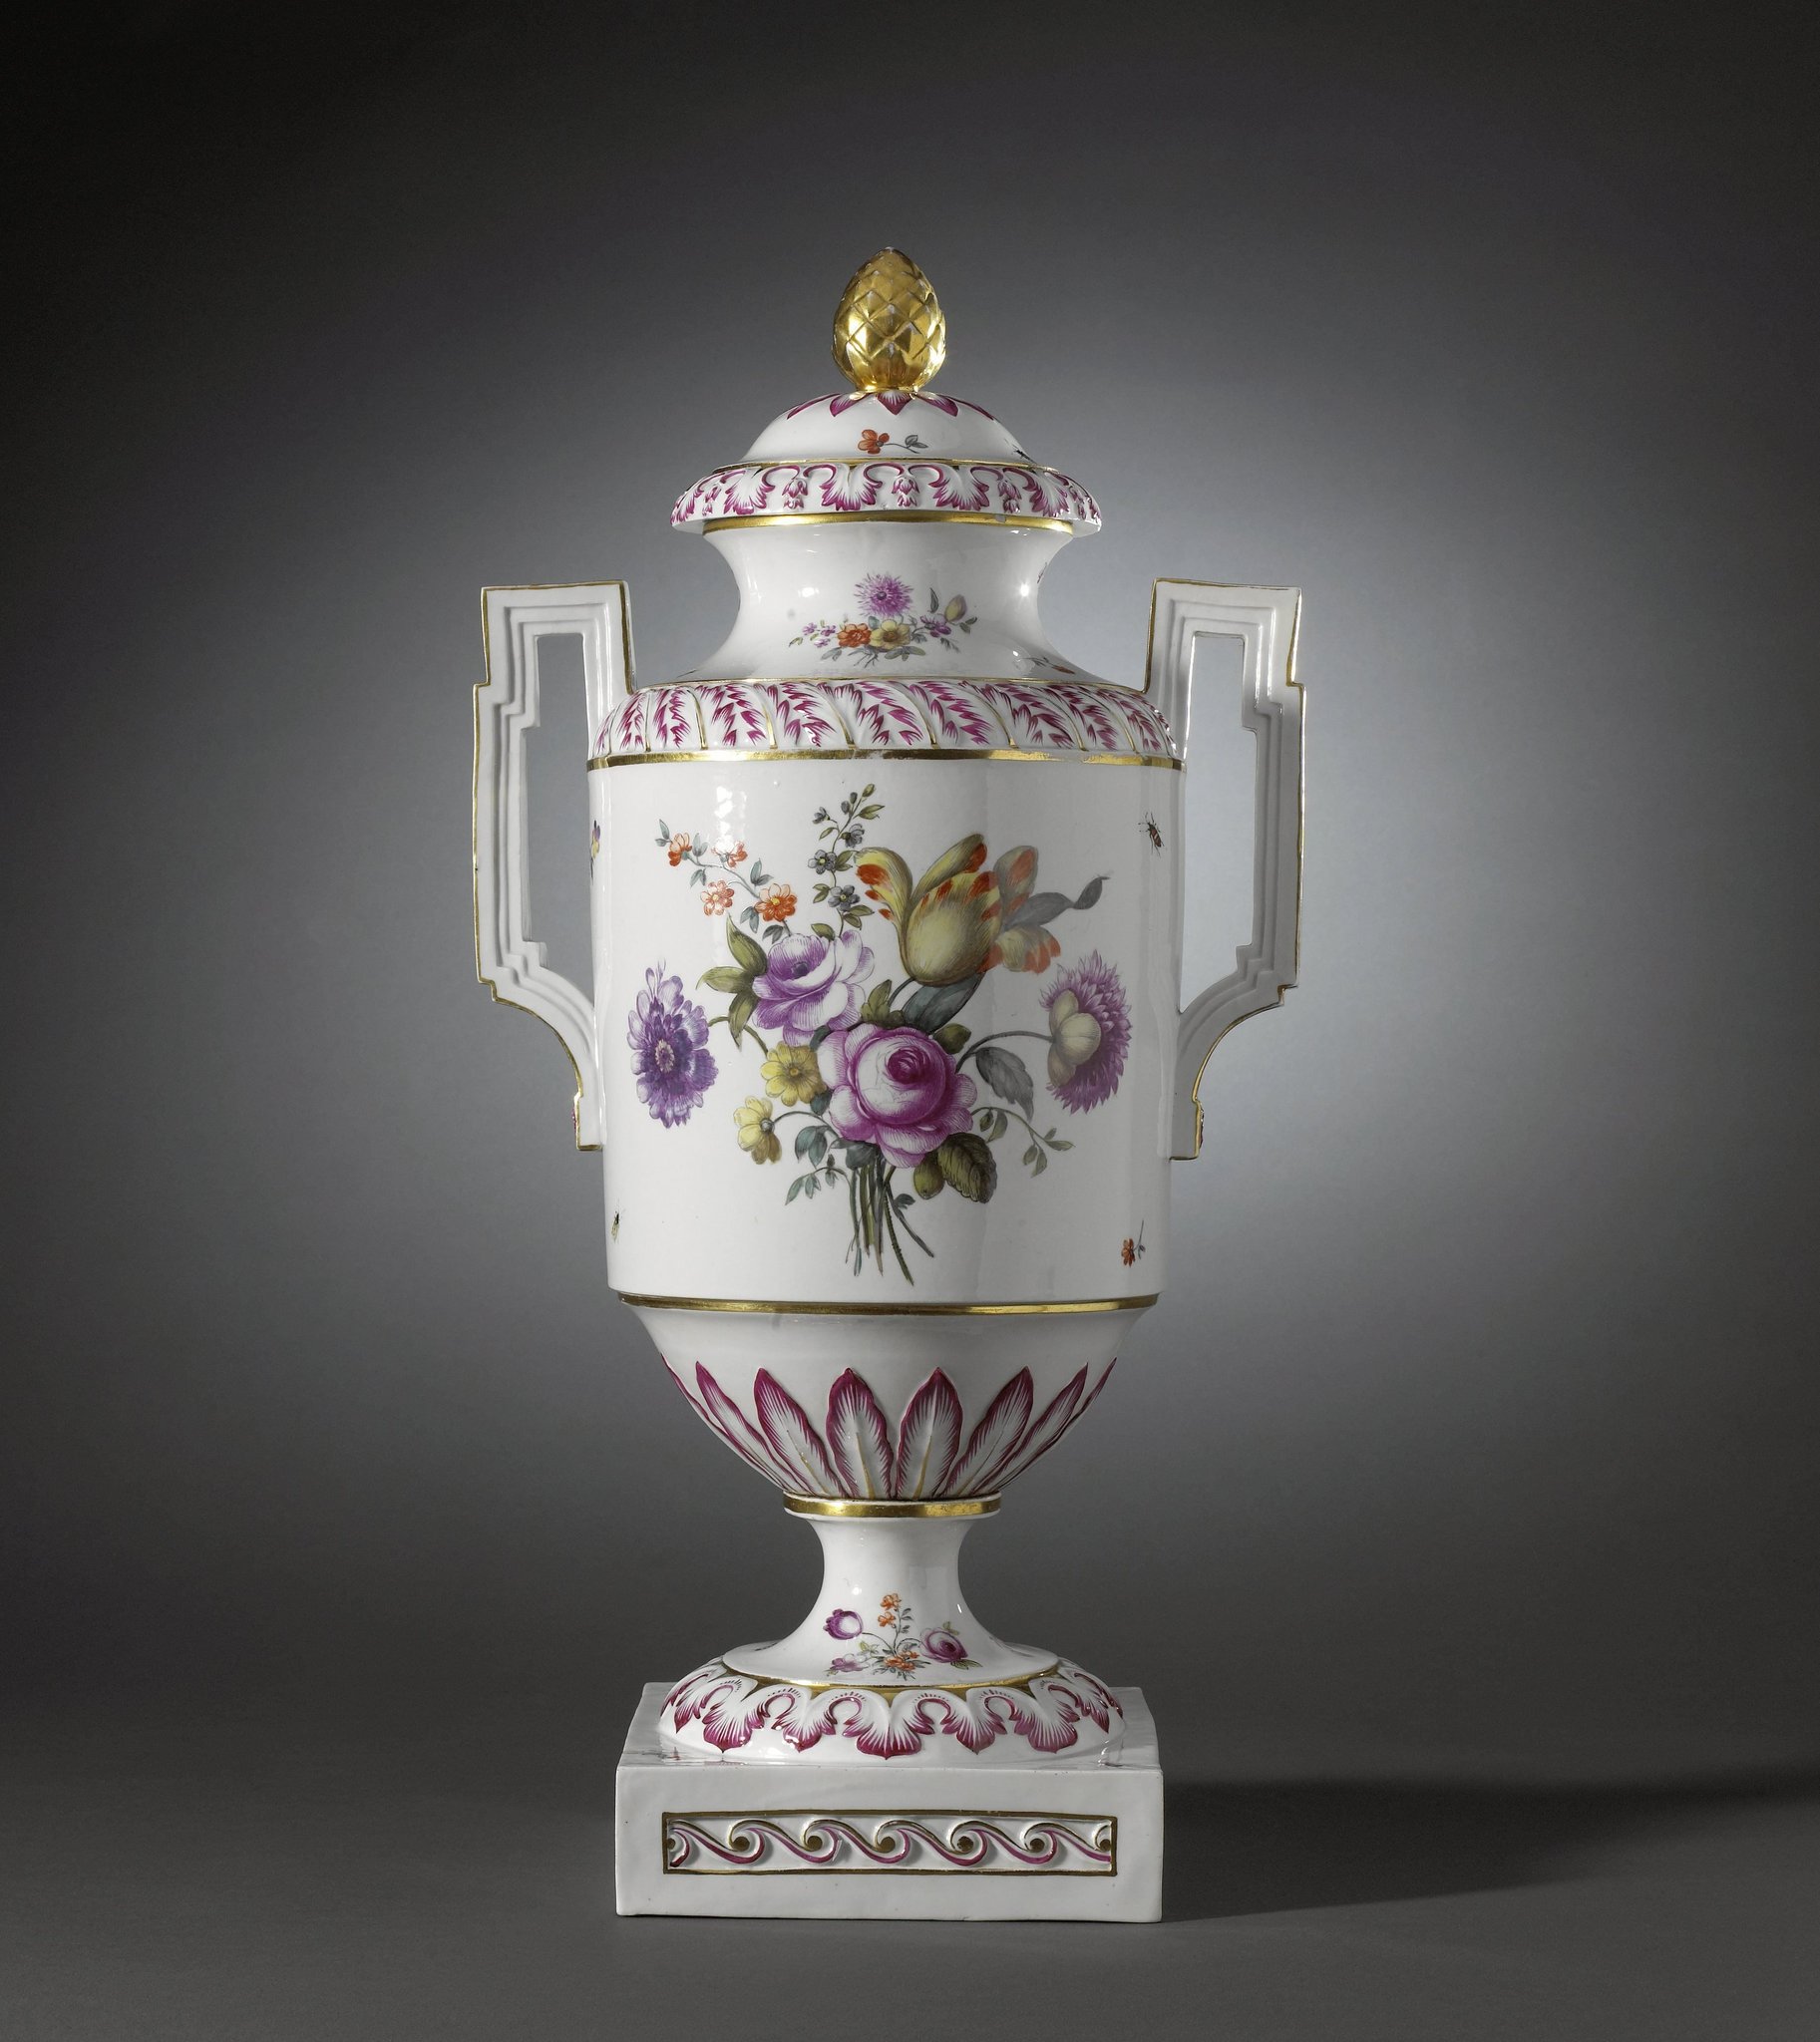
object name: dekselvaas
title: Covered vase with birds on a branch and bouquets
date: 1785-1790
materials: glaze, gold, paint, porcelain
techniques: firing, forming, gilding, relief, turning, vitrification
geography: furstenberg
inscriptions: mark: ‘F/ A.F.’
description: Dekselvaas van porselein op een spreidende voet eindigend in een vierkant voetstuk en met een cilindrisch lichaam met ronde schouder en zich vernauwend naar de voet. Spreidende nek met een platte rand en hoge, hoekige oren. Beschilderd op het glazuur in blauw, rood, roze, groen, geel, paars, zwart en goud. Op de buik twee vogels op een tak in een landschap en een boeket van verschillende bloemen. Hiertussen strooibloemen en insecten. Het vernauwende deel naar de voet met een band met gemodelleerde opstaande bladmotieven in reliëf. De schouder en de voet met dezelfde decoratie als op de buik met daaronder een band met bladranken in reliëf. Op de hoeken van het voetstuk een bloem of insect. De zijkanten met een krulmotief in bas-reliëf. Gouden rand. De deksel met bloemen en insecten en op de rand gemodelleerde bladranken; dekselknop in de vorm van een dennenappel met een gemodelleerde rozet als basis. Gemerkt op de onderzijde met de F en A.F.